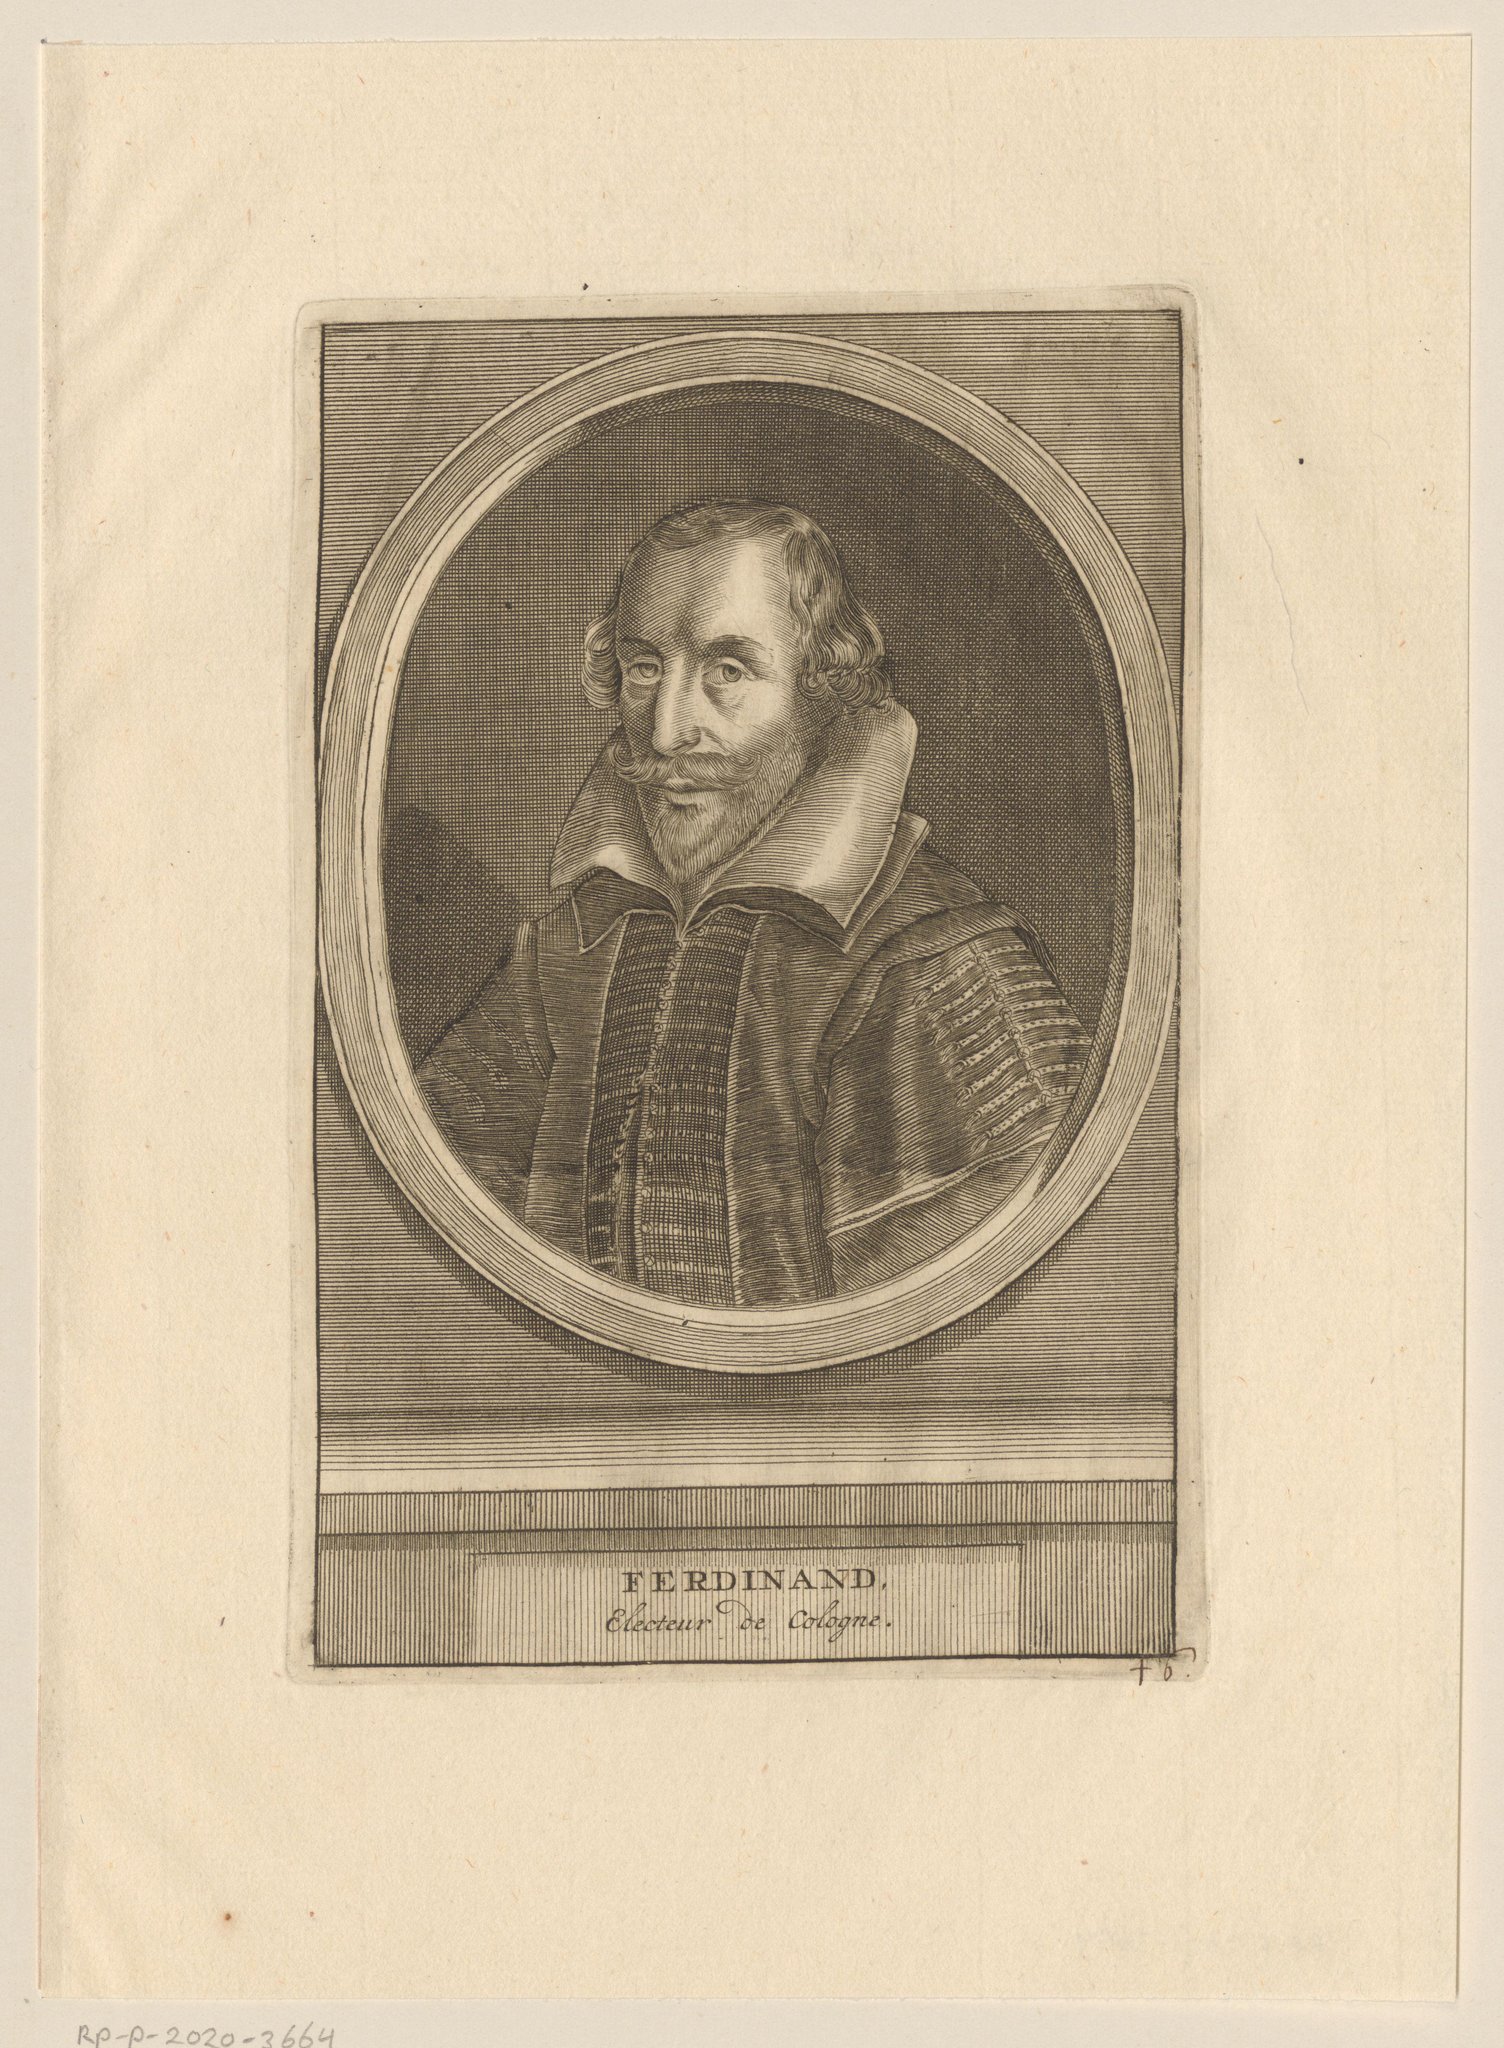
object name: print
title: Portret van Ferdinand van Beieren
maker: Anonymous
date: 1650-1750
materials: paper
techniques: etching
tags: ferdinand van beieren, historical persons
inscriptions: inscription: ‘+6’